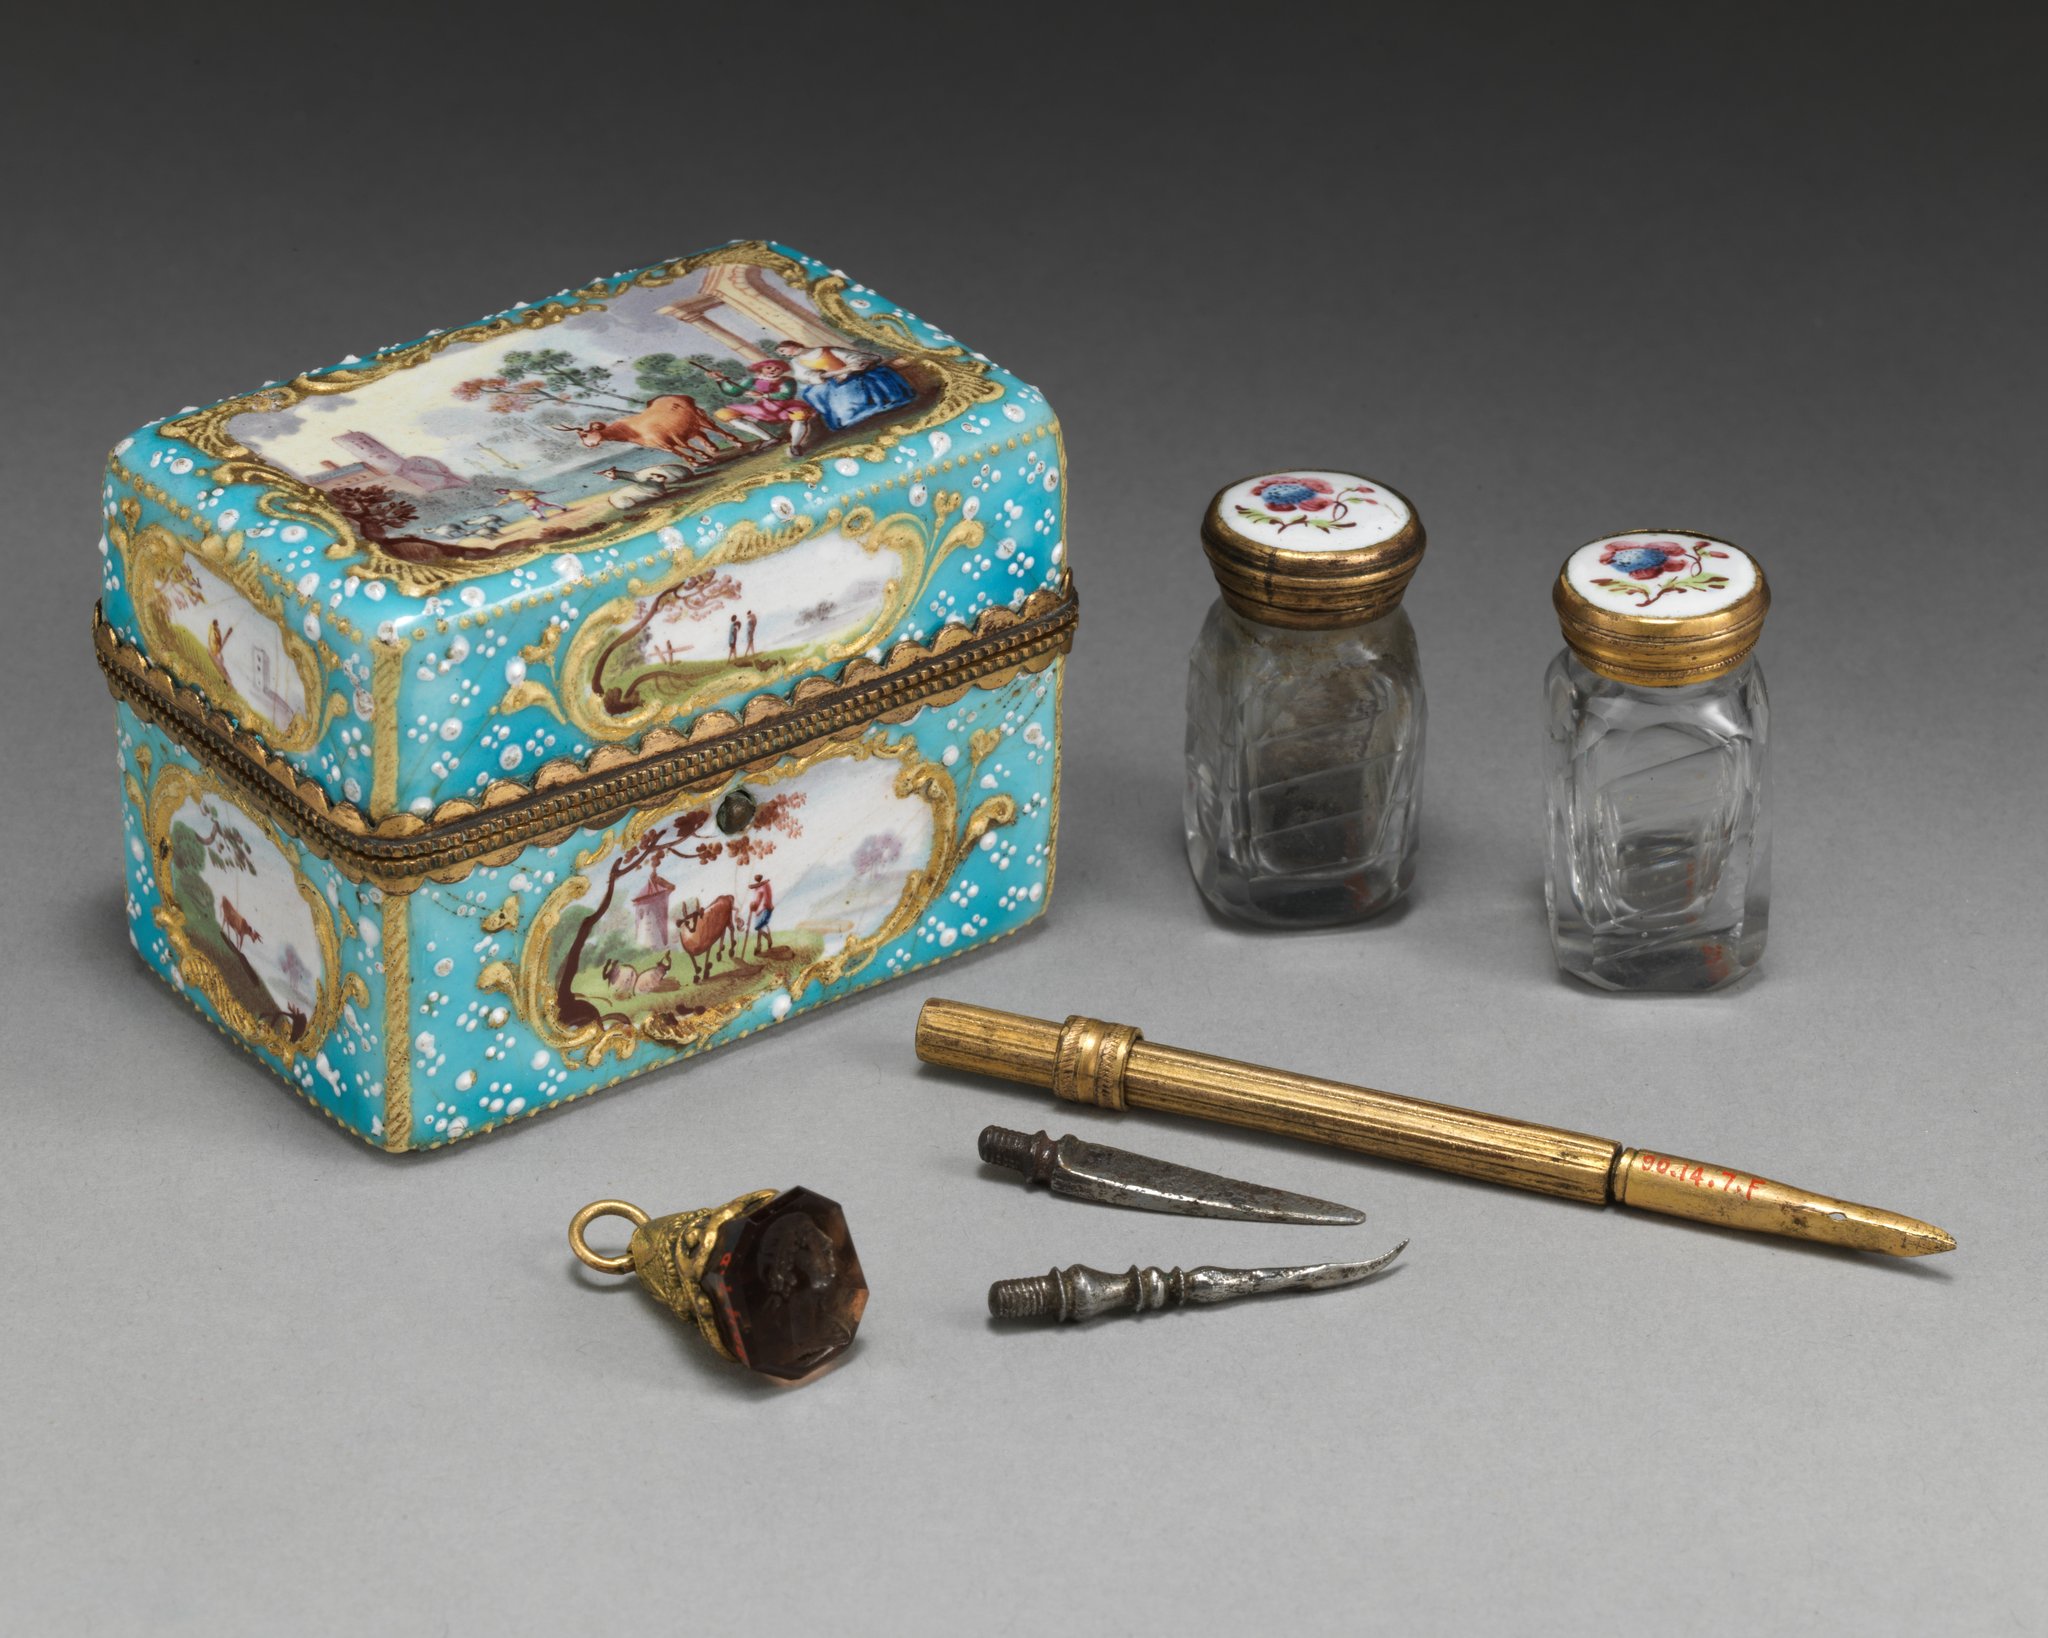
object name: nécessaire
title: Writing Nécessaire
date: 1765-1770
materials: copper, enamel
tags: animals,men,women